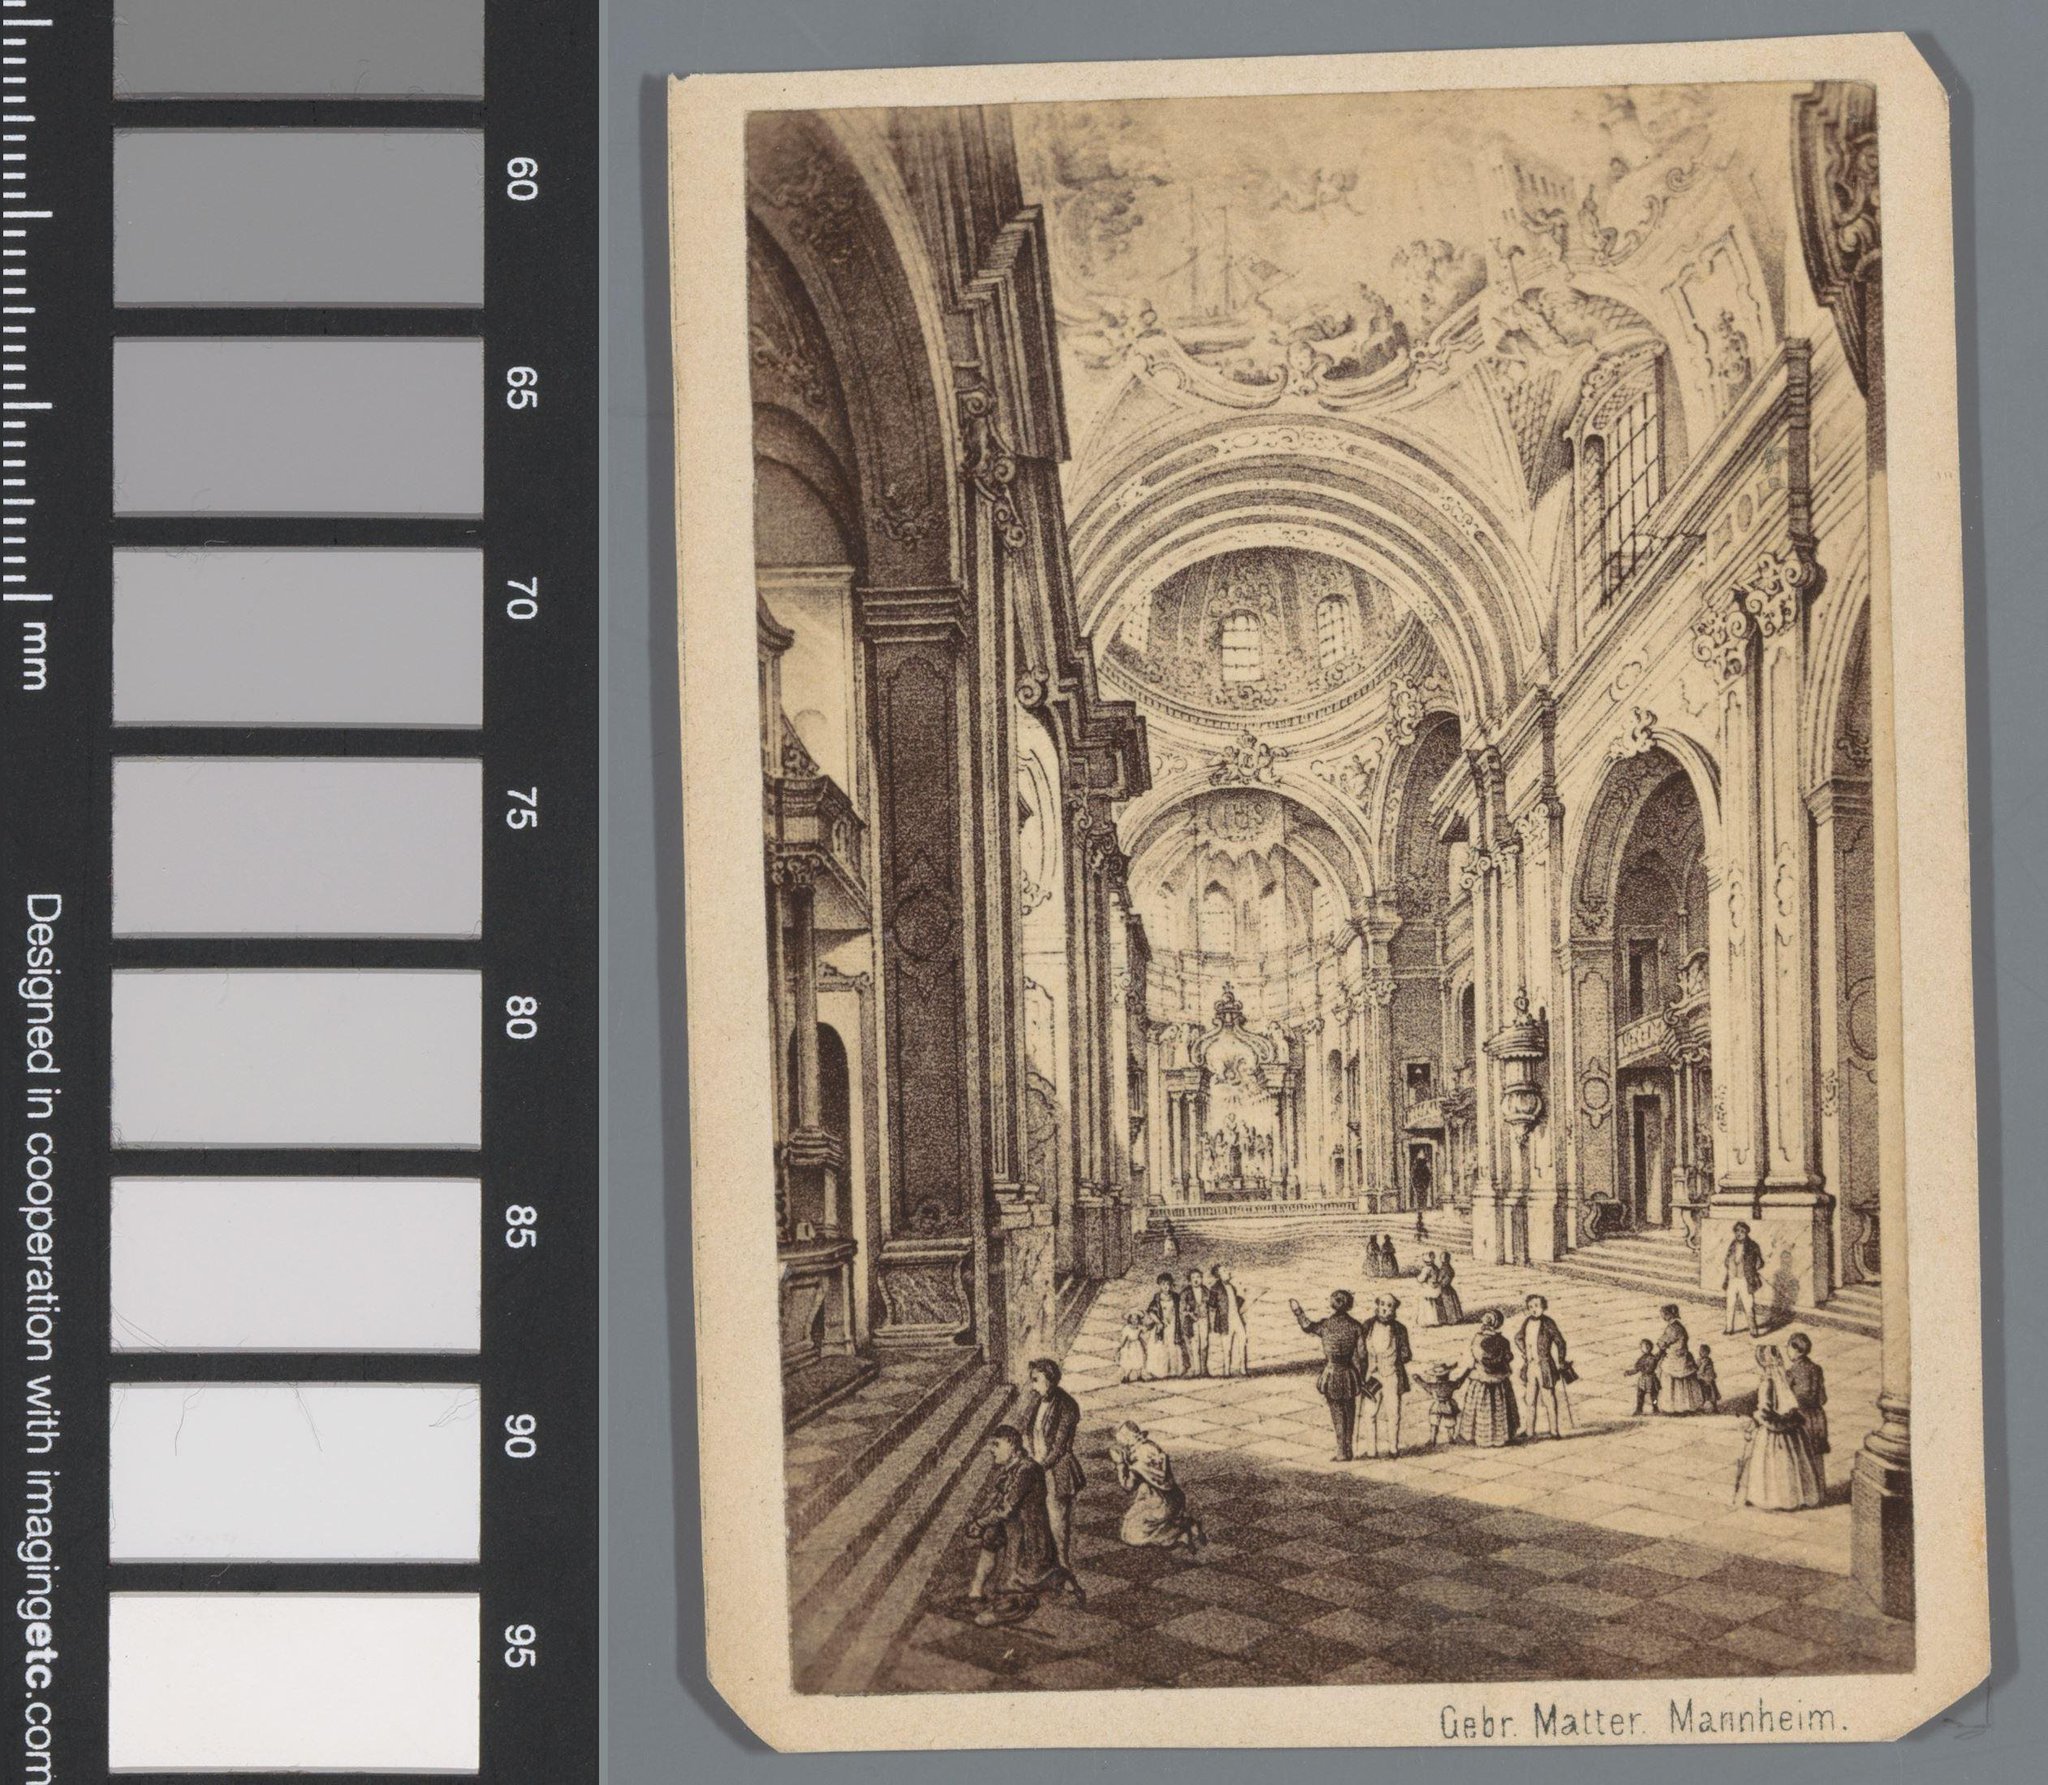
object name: carte de visite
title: Fotoreproductie van een prent van de Jezuïetenkerk in Mannheim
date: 1861-1899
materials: cardboard, paper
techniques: albumen print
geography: mannheim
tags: parts of church interior: nave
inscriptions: stamp: ‘C. F. HECKEL/ MANNHEIM’